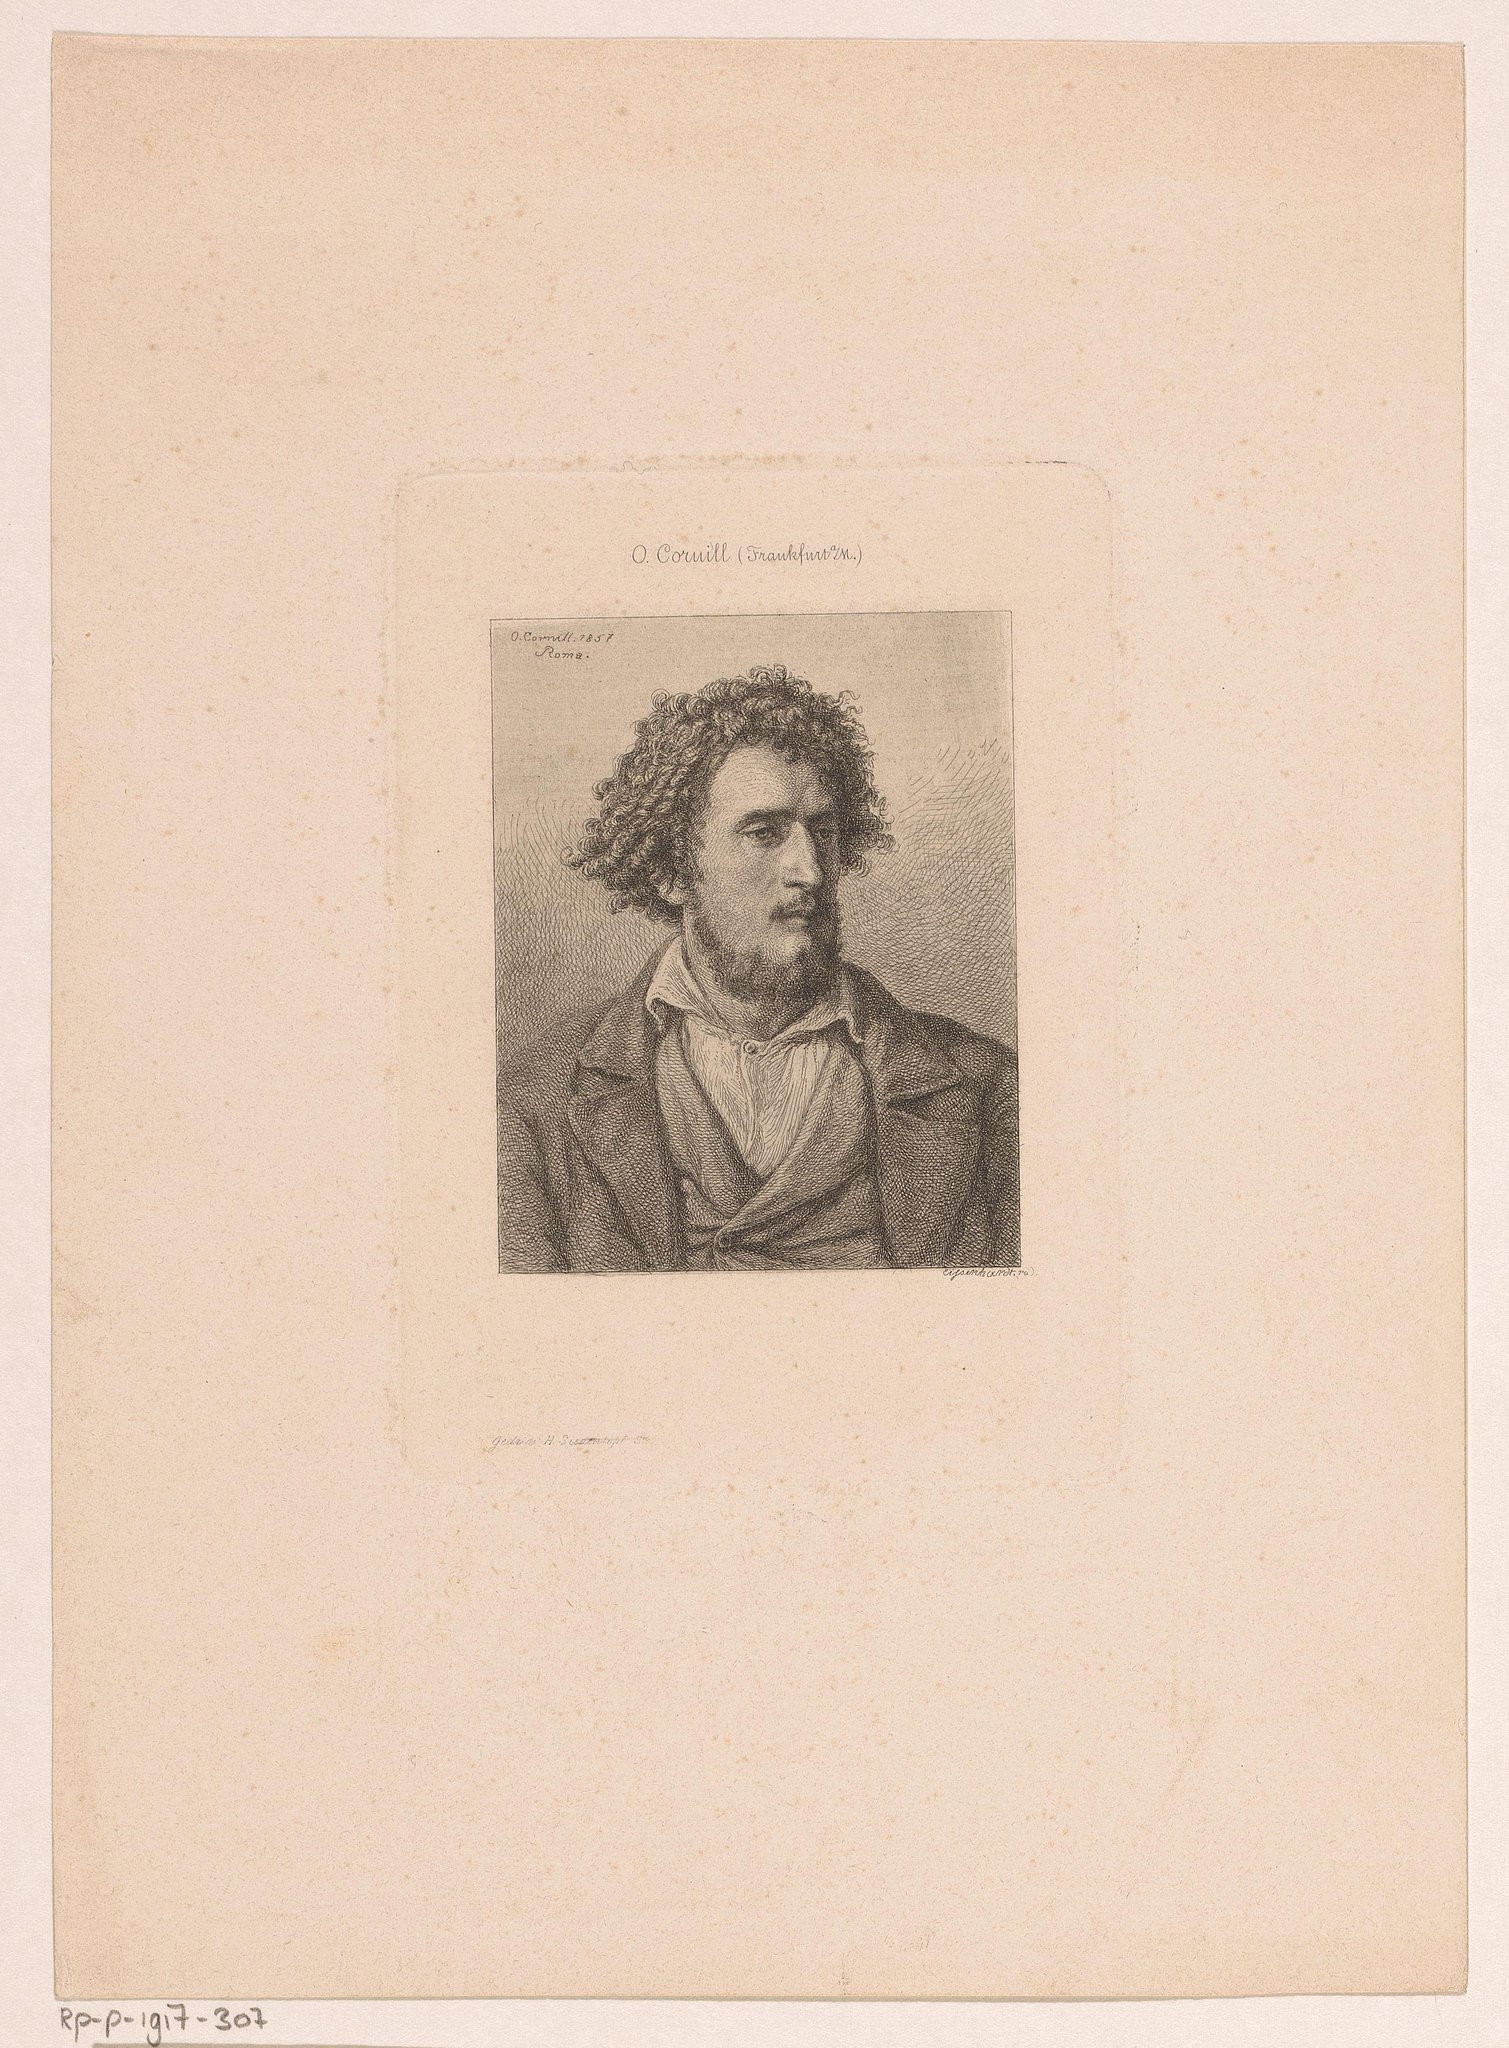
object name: print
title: Portret van een onbekende man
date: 1857-1896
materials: paper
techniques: etching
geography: rome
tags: historical persons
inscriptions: collector's mark: Lugt 2228